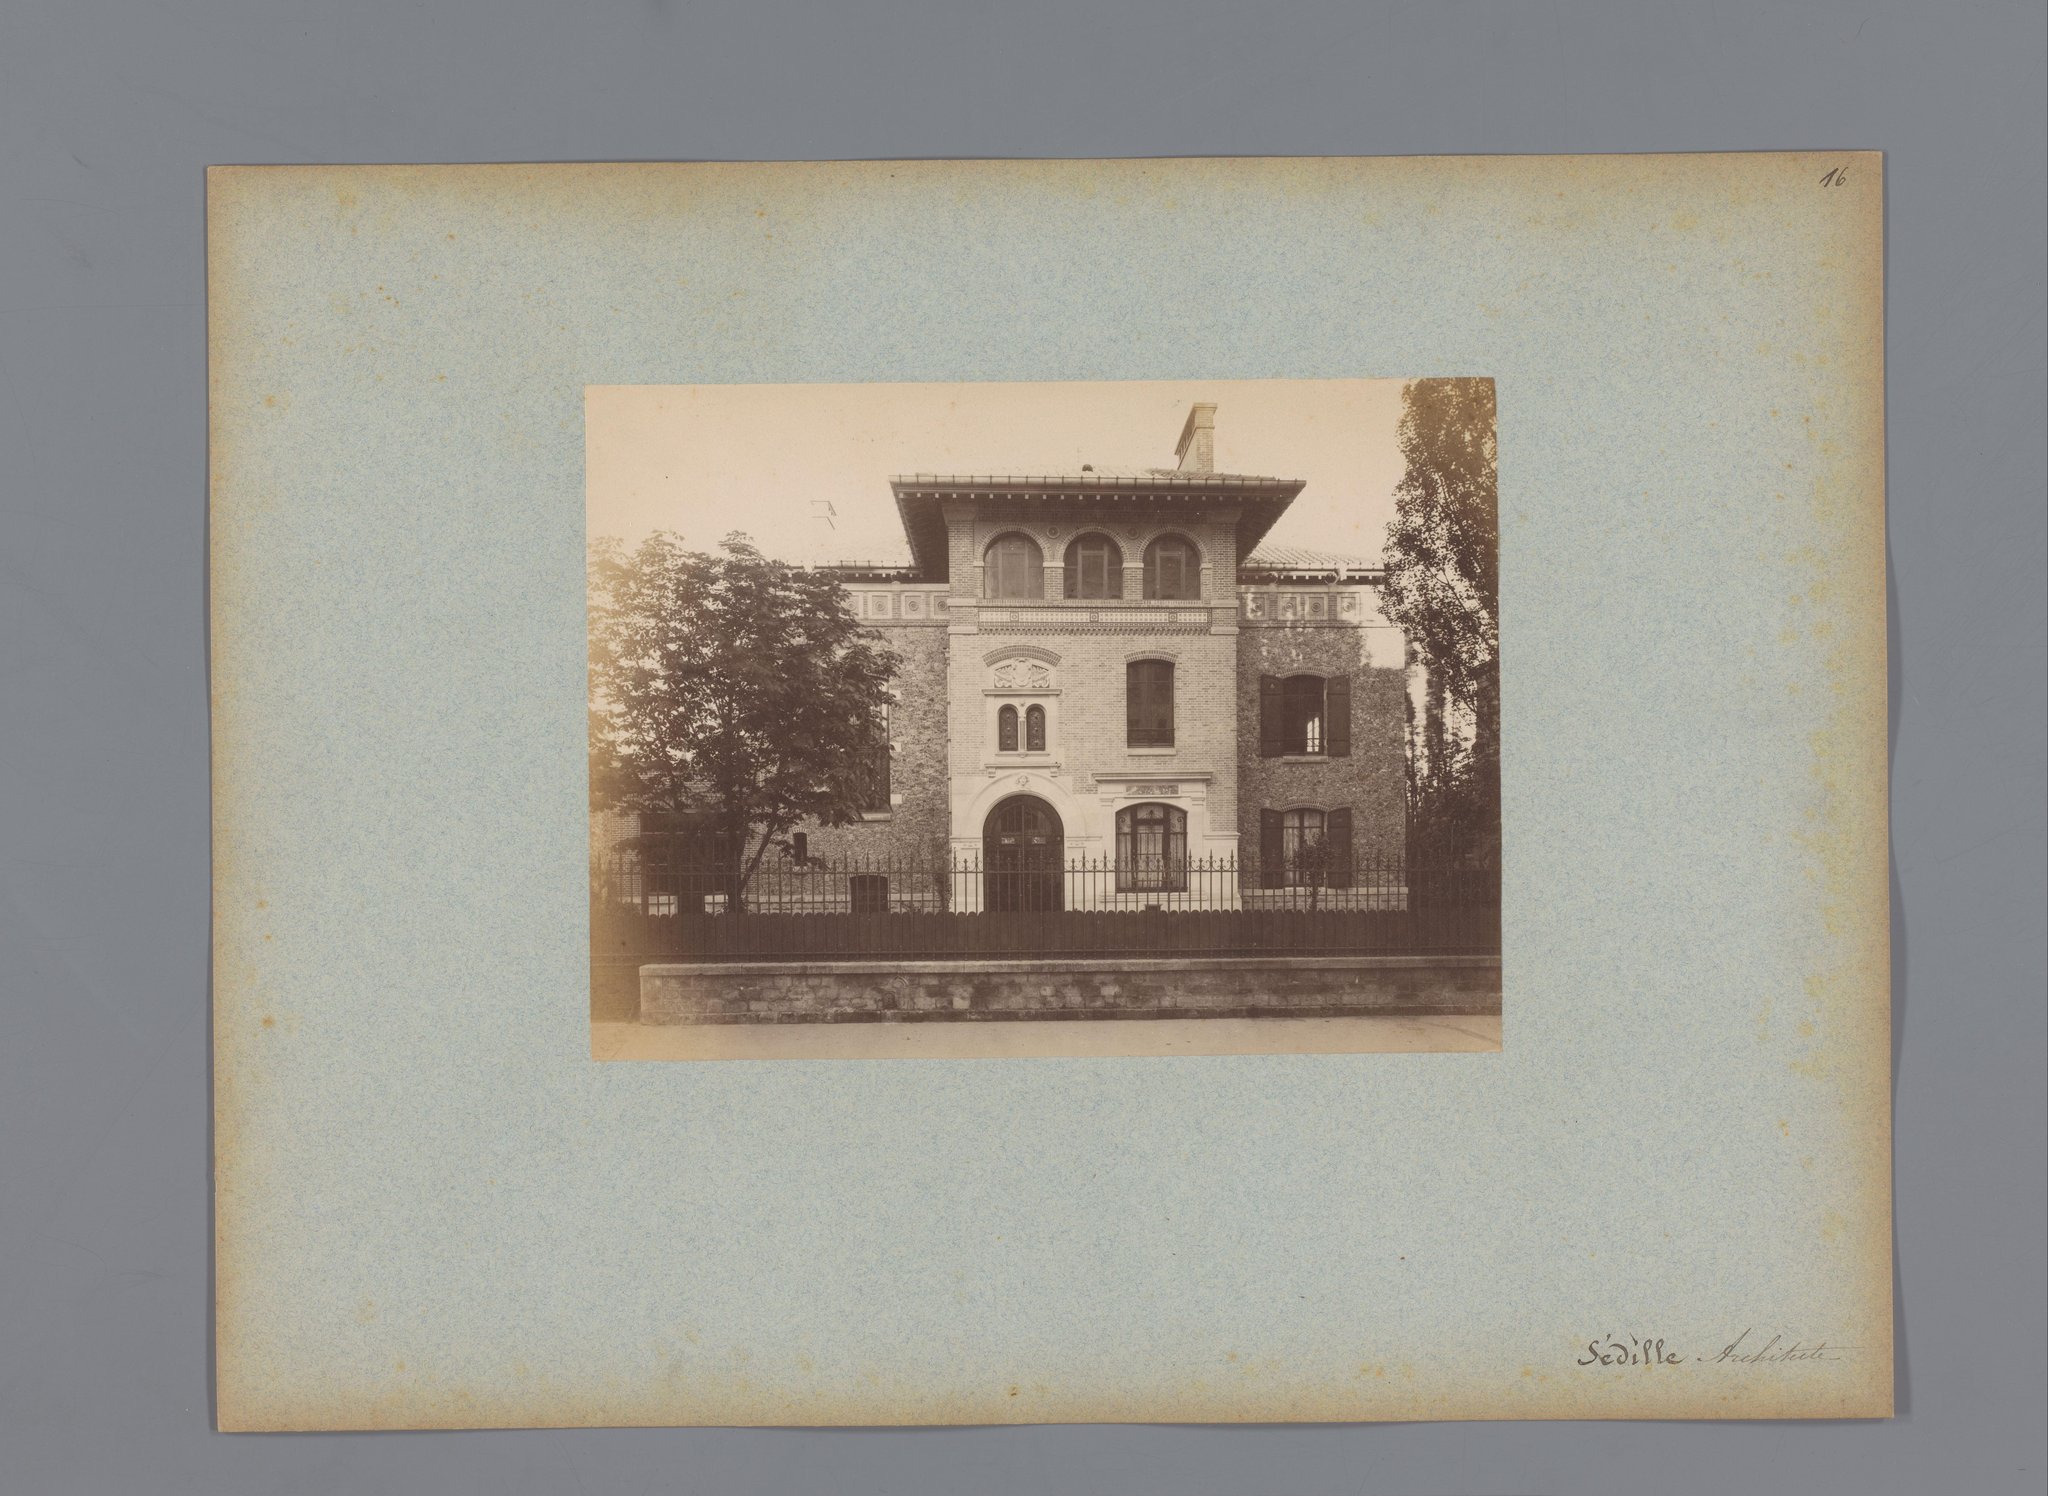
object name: photograph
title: Façade van een villa in Parijs, ontworpen door Paul Sédille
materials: photographic support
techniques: albumen print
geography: paris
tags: detached house in city, façade (of house or building), paris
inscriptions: number: ‘16’, name: ‘Sédille Architecte’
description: Deze foto maakt deel uit van een omslag met 35 foto's en een titelblad.